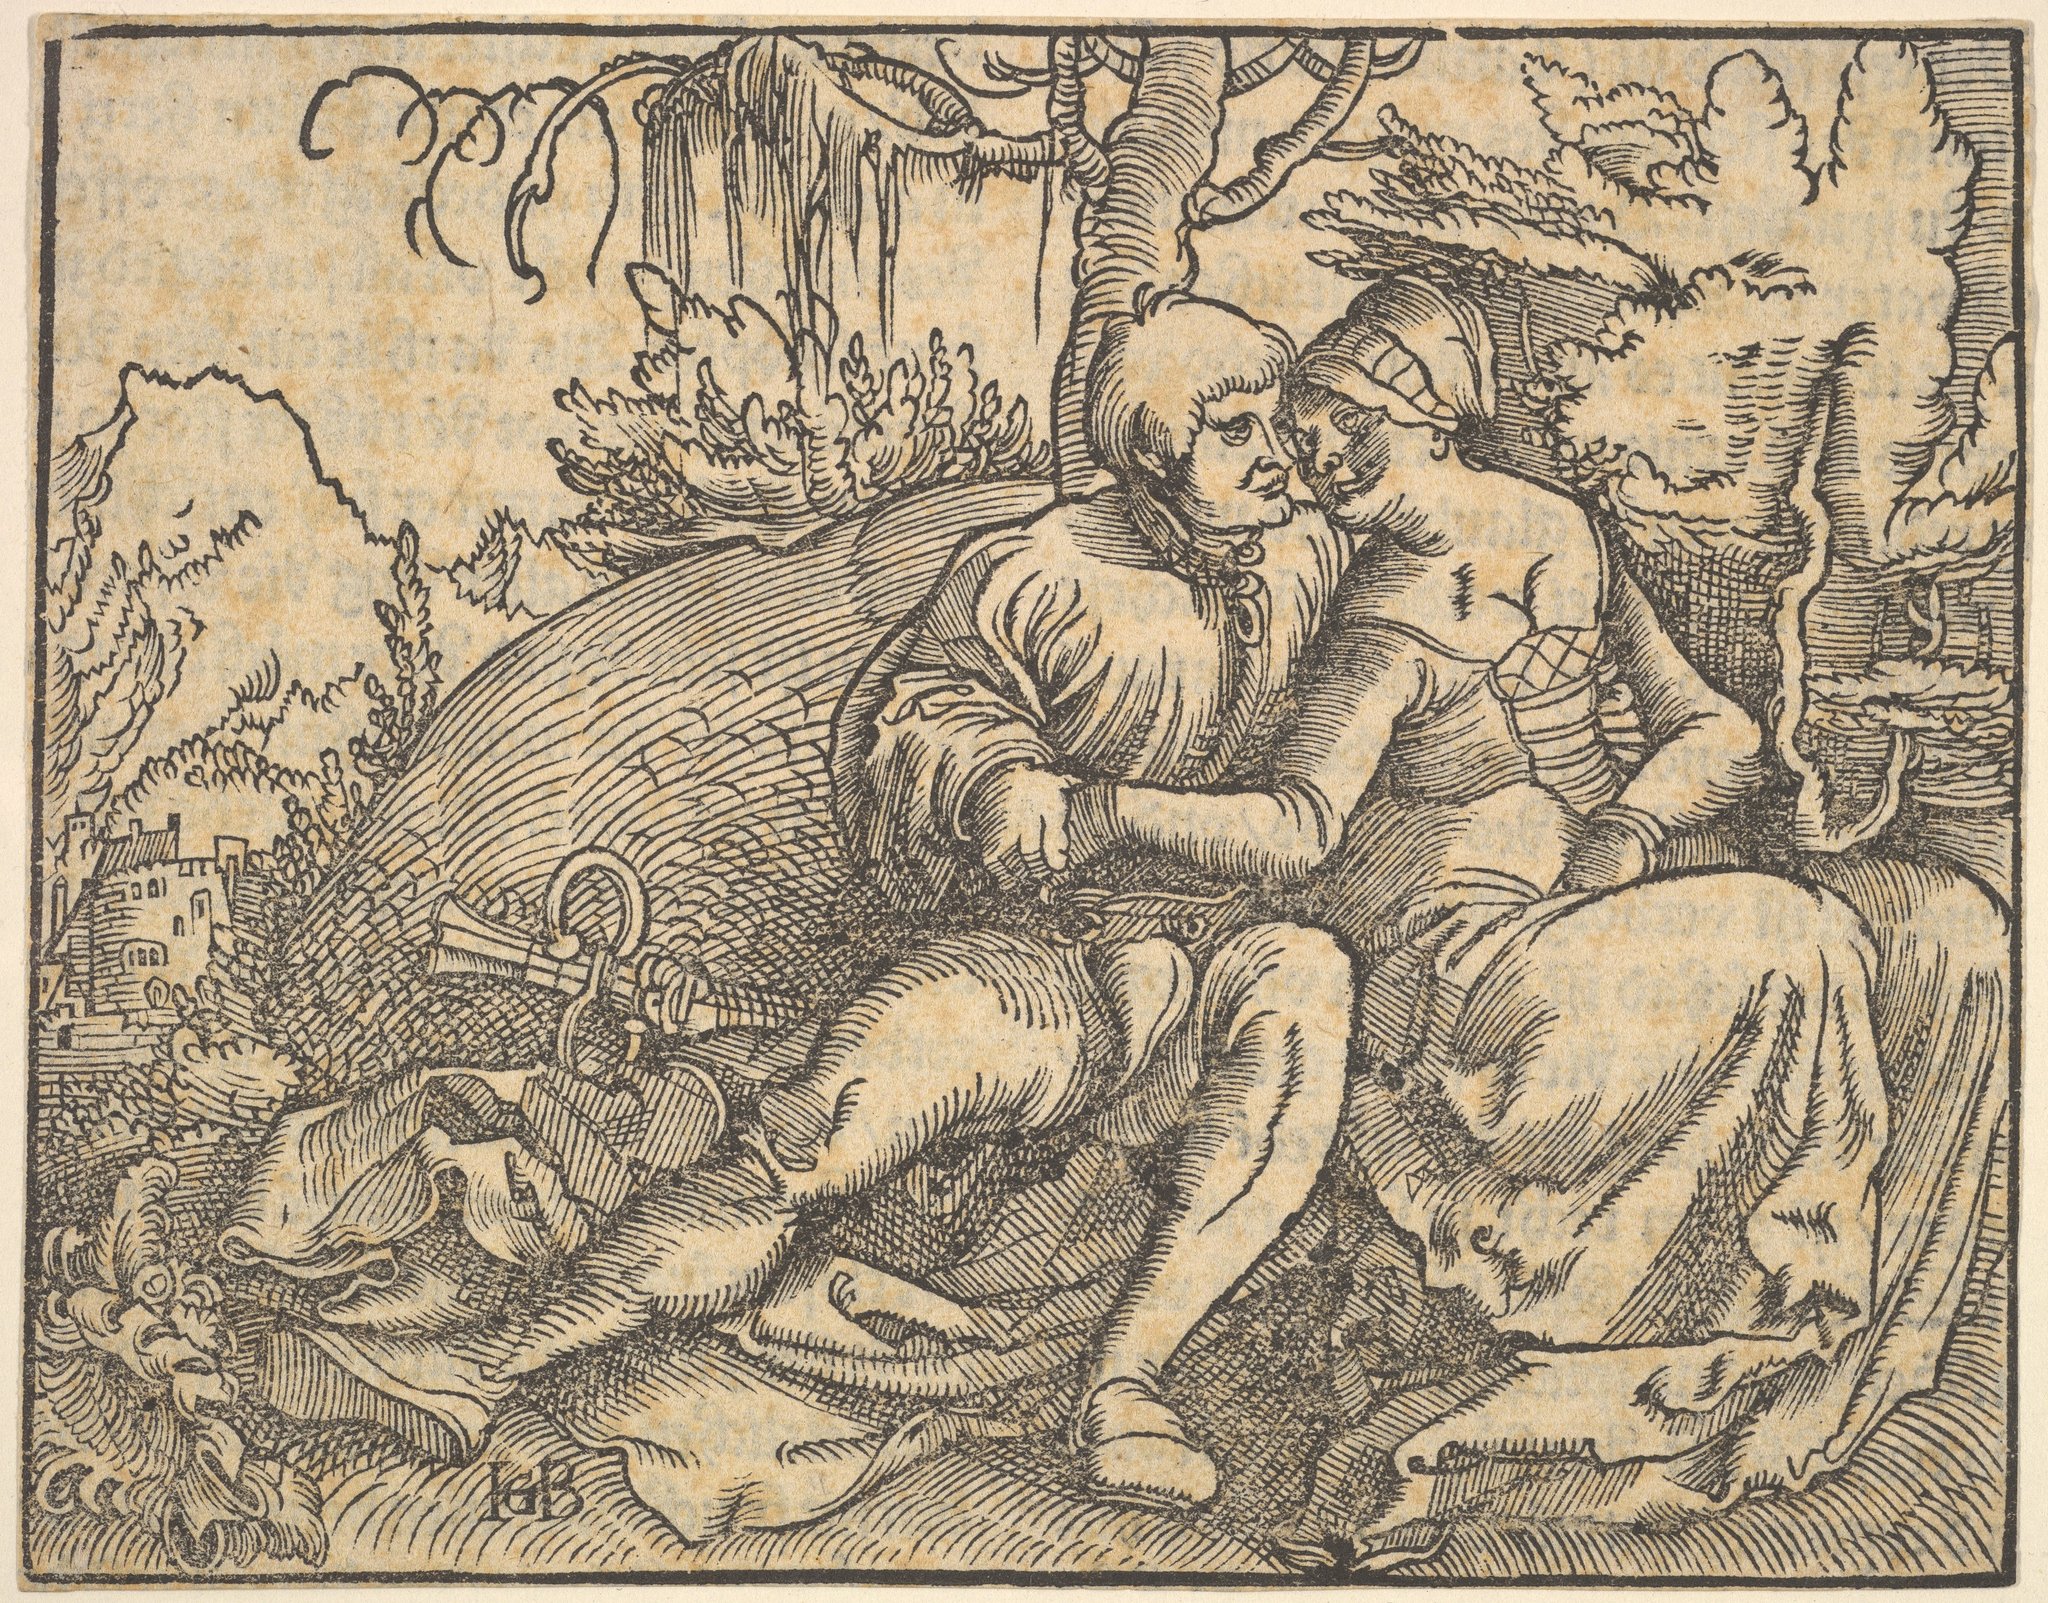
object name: print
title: The Sixth of Ten Commandments, from "Die zehe gebot"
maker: hans baldung (called hans baldung grien)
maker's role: artist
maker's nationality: german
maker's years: 1484-1545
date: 1500-1545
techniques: letterpress, woodcut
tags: couples,men,women,landscapes